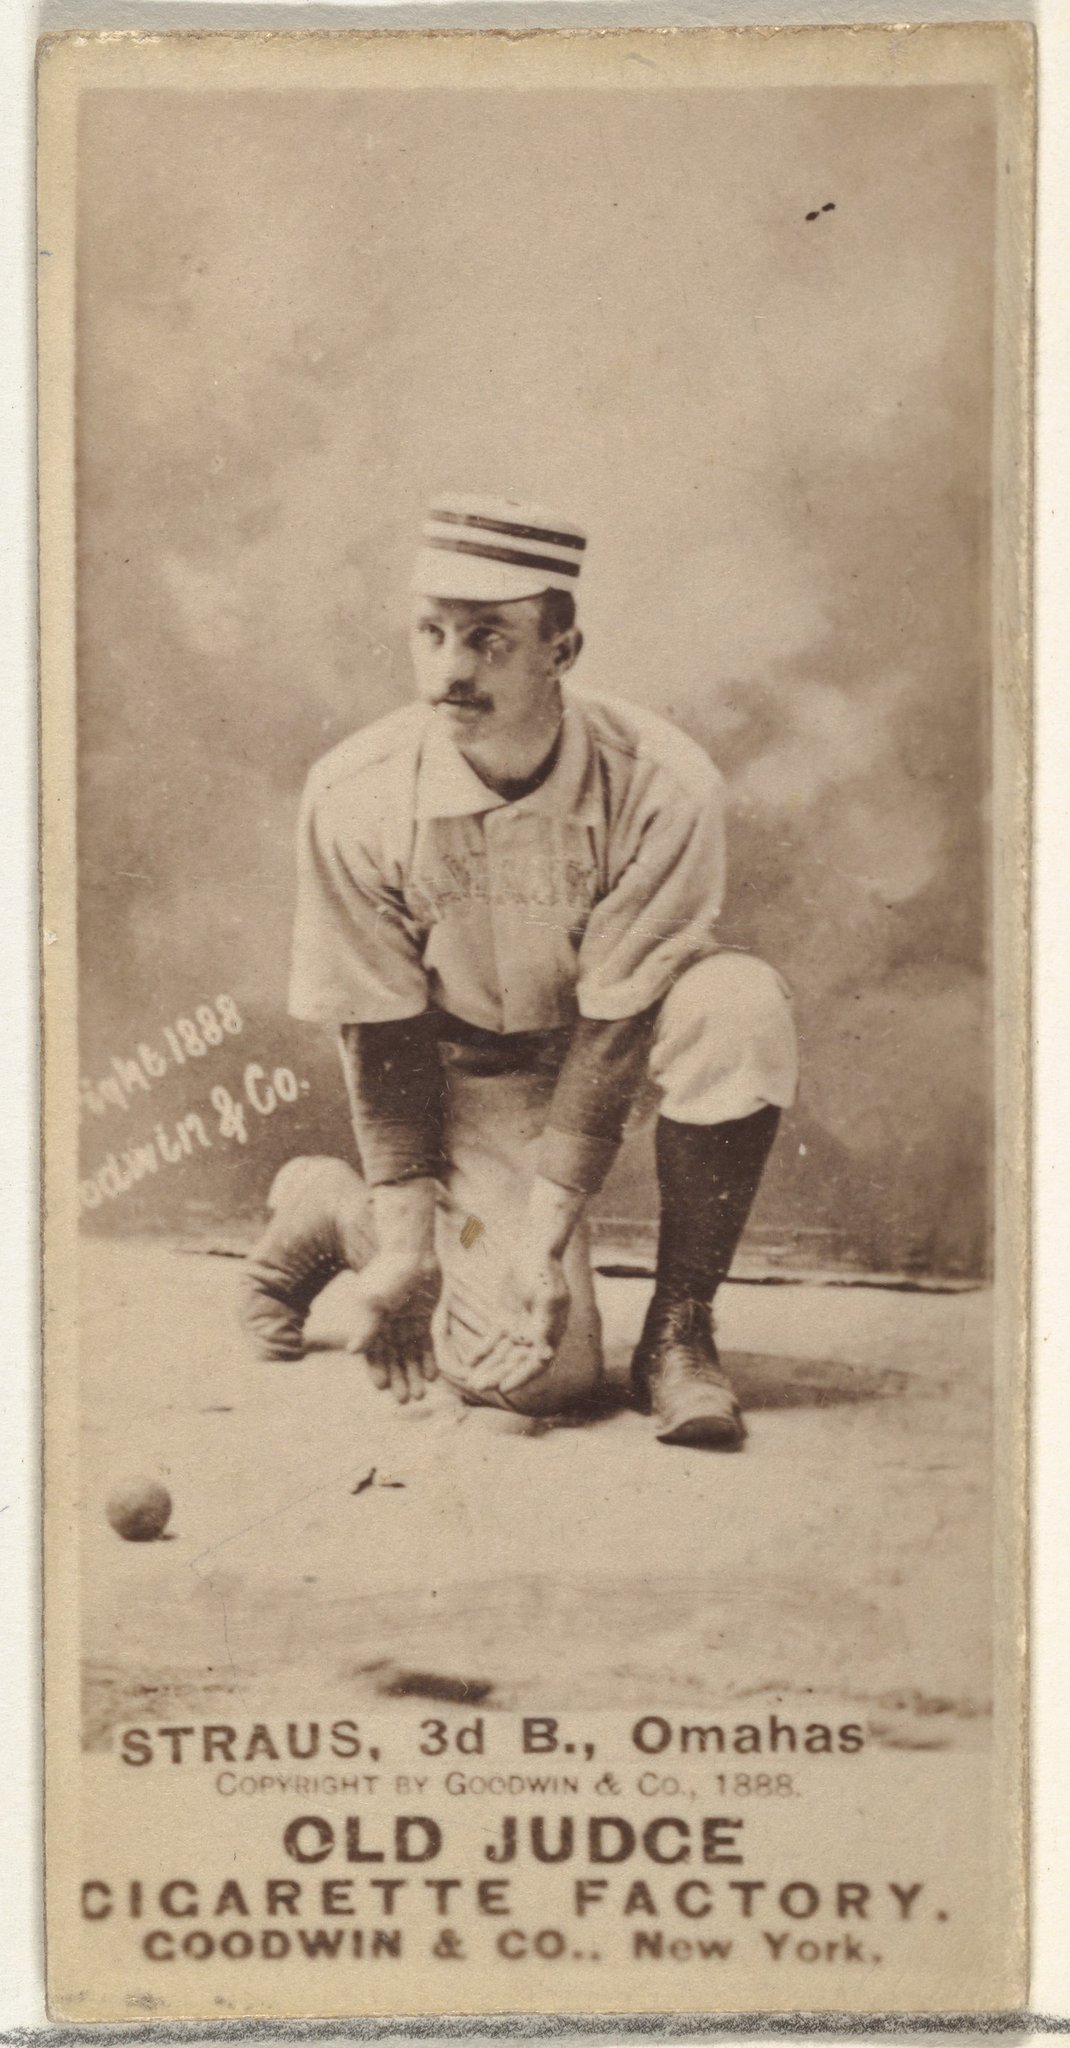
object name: baseball card, photograph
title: Joseph "Joe" Strauss, 3rd Base, Omaha Omahogs/ Lambs, from the Old Judge series (N172) for Old Judge Cigarettes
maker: goodwin & company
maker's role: publisher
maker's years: 1850-1950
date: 1888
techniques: albumen silver print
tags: men,portraits,baseball,athletes